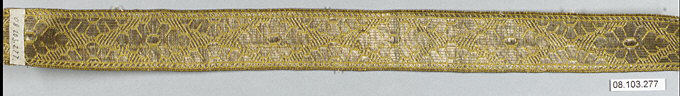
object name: galloon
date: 1801-1833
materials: metal thread, silk